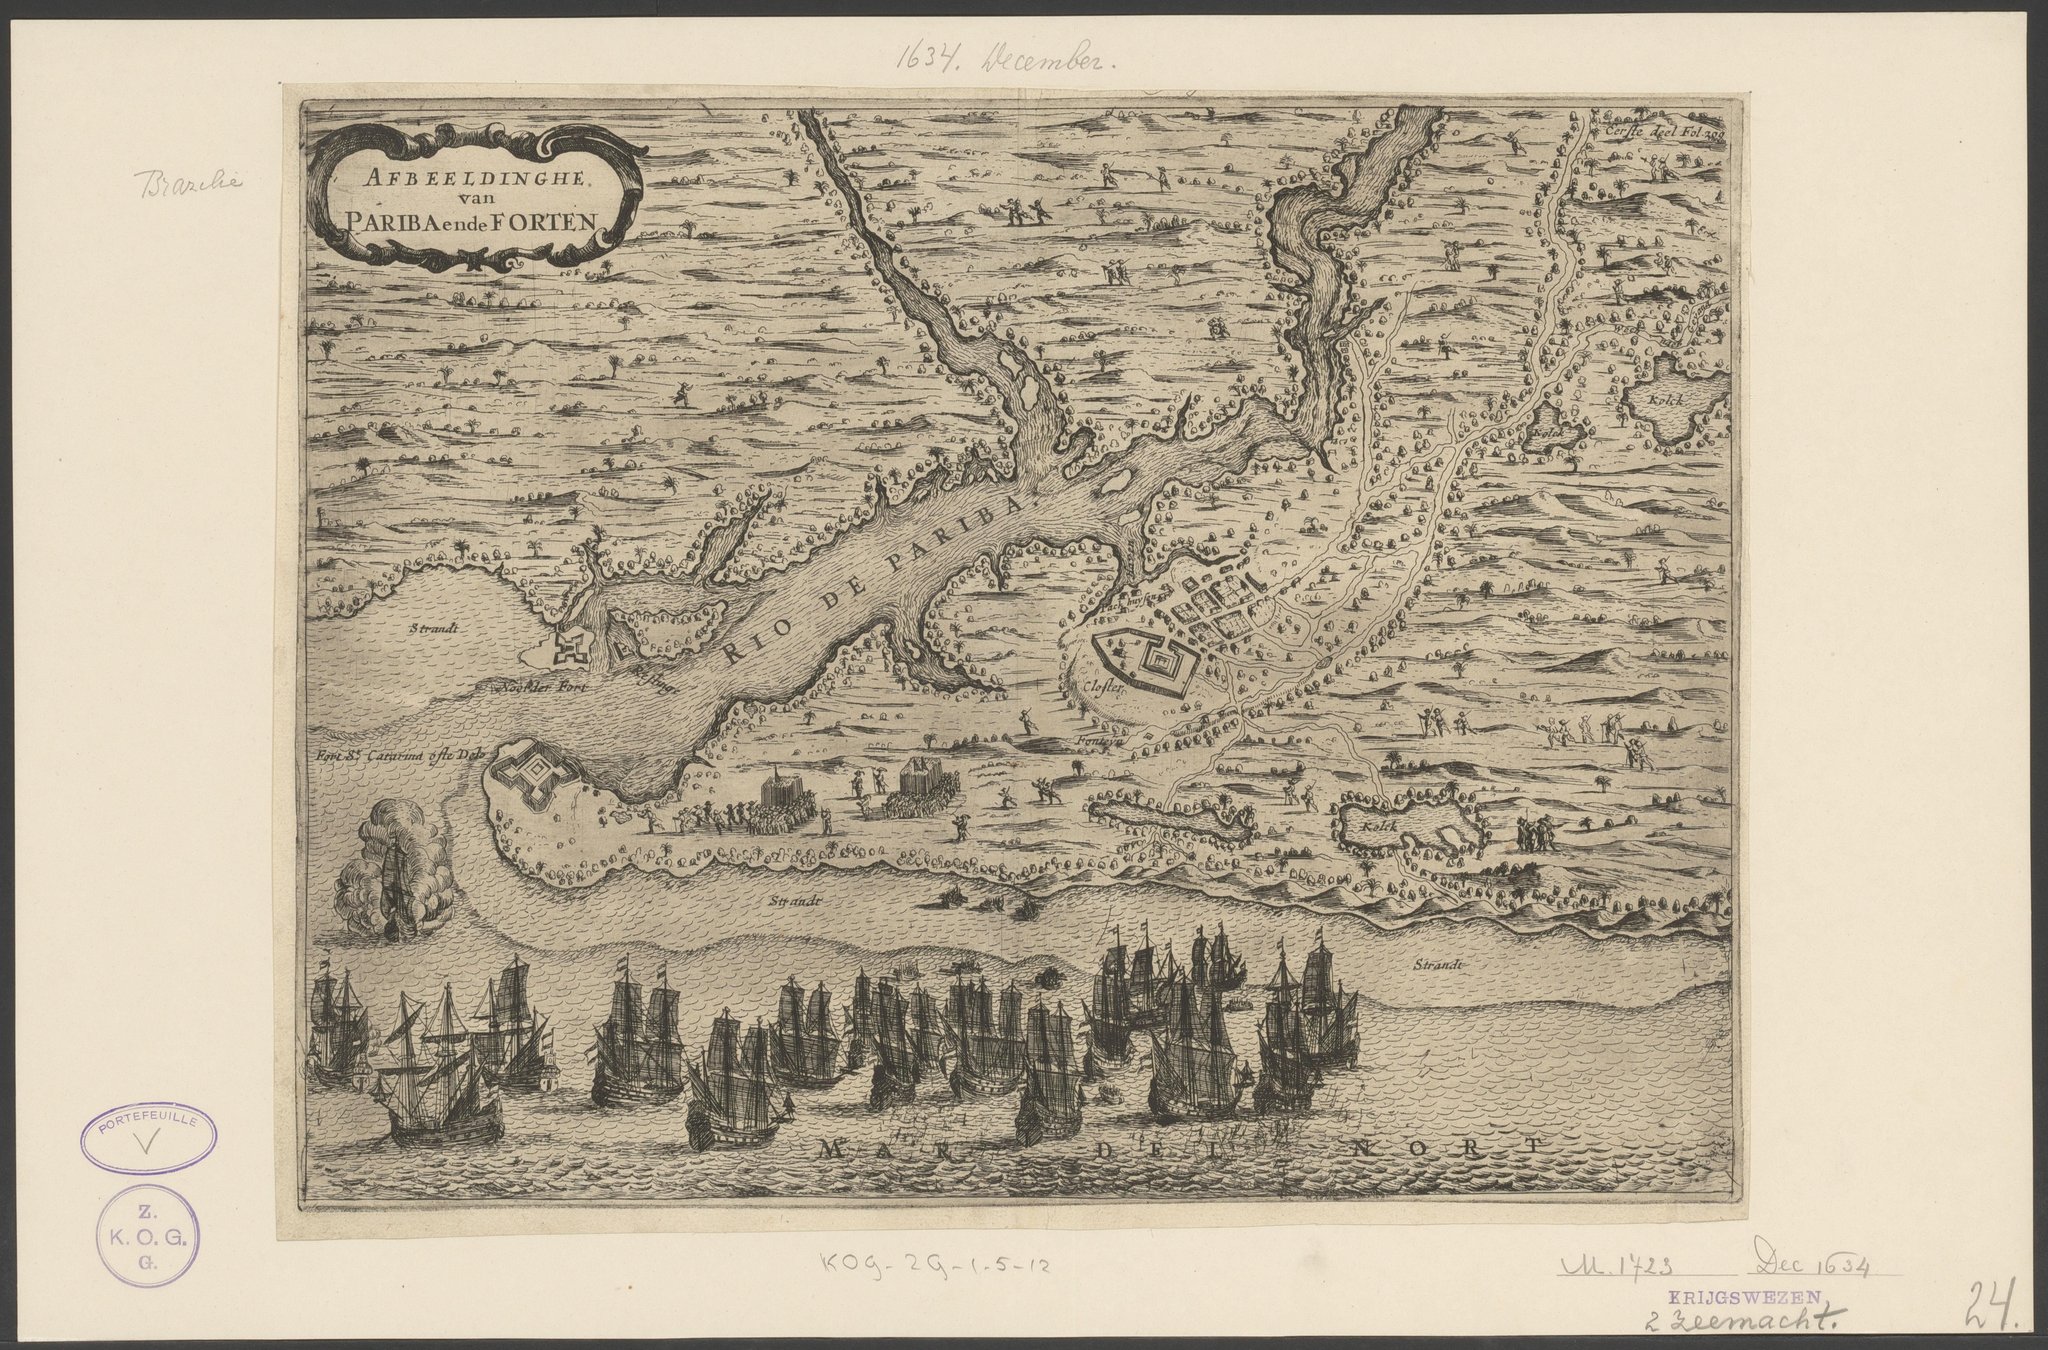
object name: book illustration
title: Forten aan de monding van de Rio Paraiba in Brazilië veroverd door admiraal Lichthart, 1634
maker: Anonymous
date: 1652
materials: paper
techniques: engraving, etching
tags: sailing-ship, sailing-boat, maps of separate countries or regions, capture of city (after the siege), brasil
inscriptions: collector's mark: Lugt 1641, stamp, stamp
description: Prent mogelijk uit: Commelin, Isaak. Frederick Hendrick van Nassauw prince van Orangien zyn leven en bedryf. Utrecht: Wed. Esdras Willemsz Snellaert en Gerrit Nieuwenhuysen, 1652, fol.209. Spiegelbeeldige kopie naar de prent in de uitgave van Jodocus Janssonius van 1651. Muller beschrijft deze prent (ten onrechte) als het origineel afkomstig uit Commelin 1651. Volgens de beschrijving van deze prent in de Atlas van Stolk (nr. 1933/19) heeft het origineel het opschrift in de linkerbovenhoek en niet in de rechterbovenhoek, zoals hier het geval is.